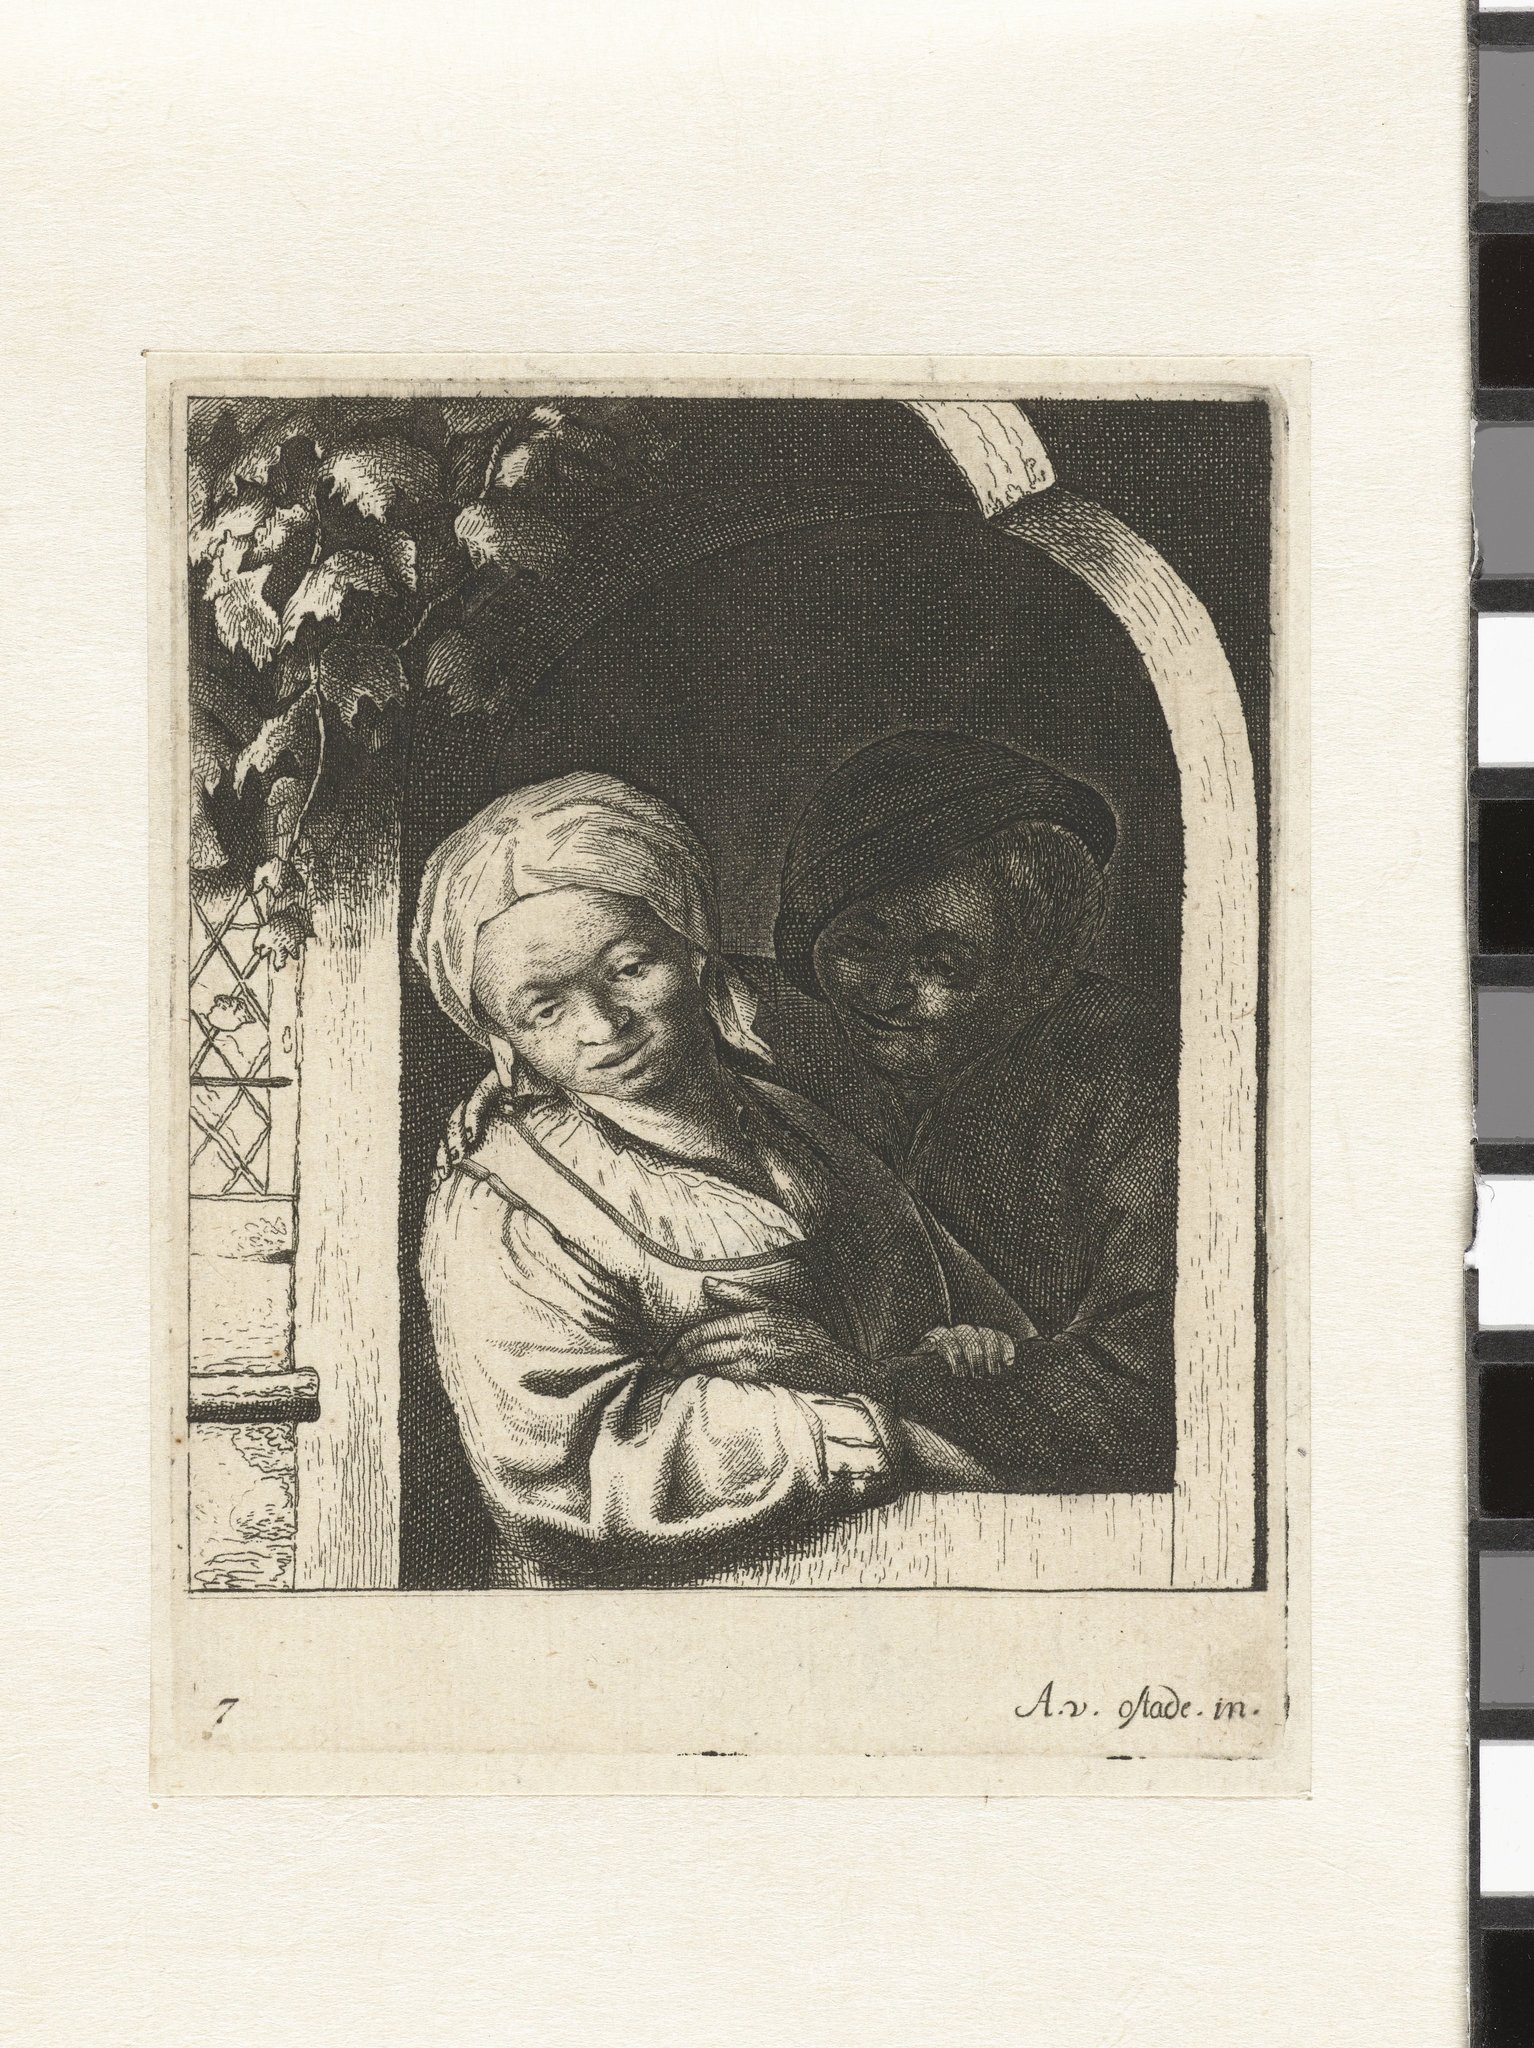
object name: print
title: Boerenliefde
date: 1650-1745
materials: paper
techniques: etching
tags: couple of lovers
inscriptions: collector's mark: Lugt 2228a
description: Boer en boerin als liefdespaar in deuropening, kopie naar prent van Adriaen van Ostade op kleiner formaat en spiegelverkeerd weergegeven.